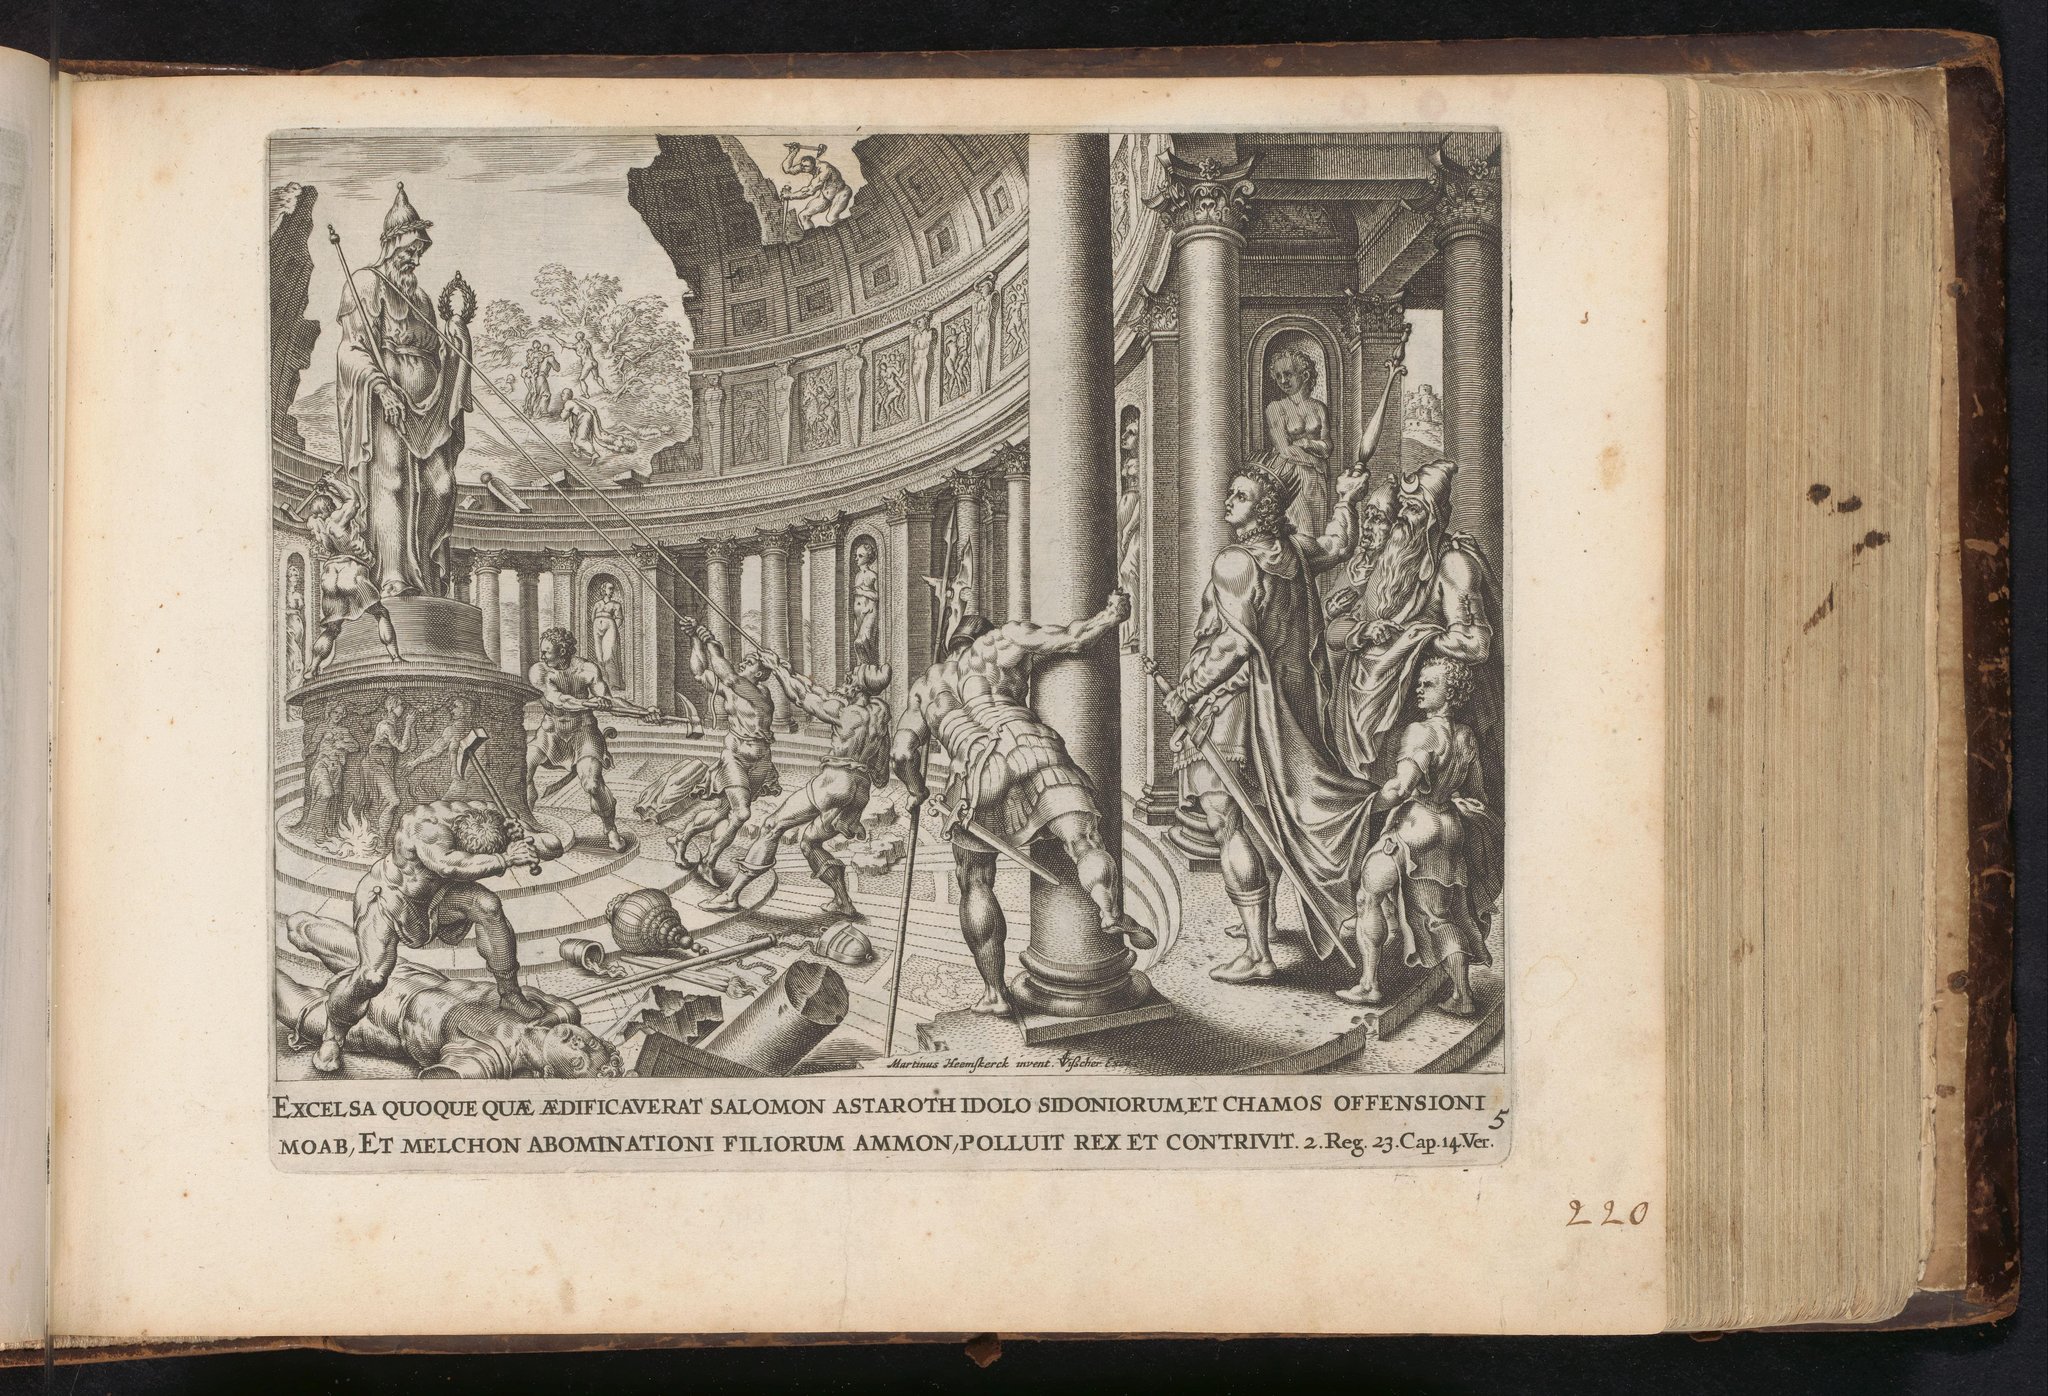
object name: print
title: Van den Coninck Josias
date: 1643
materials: paper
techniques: engraving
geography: amsterdam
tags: all the pagan shrines over the entire kingdom are desecrated and destroyed ~ story of josiah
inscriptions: number: ‘220’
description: Koning Josia laat de tempels ter ere van de heidense goden Astarte, Kemos en Milkom verwoesten en alle beelden van de afgoden in stukken slaan. Twee mannen zijn bezig om een groot standbeeld van zijn sokkel te trekken. Andere mannen slaan met hamers de tempel aan stukken. Onder de voorstelling een verwijzing in het Latijn naar de Bijbeltekst in 2 Kon. 23:14. Deze prent maakt deel uit van een album.